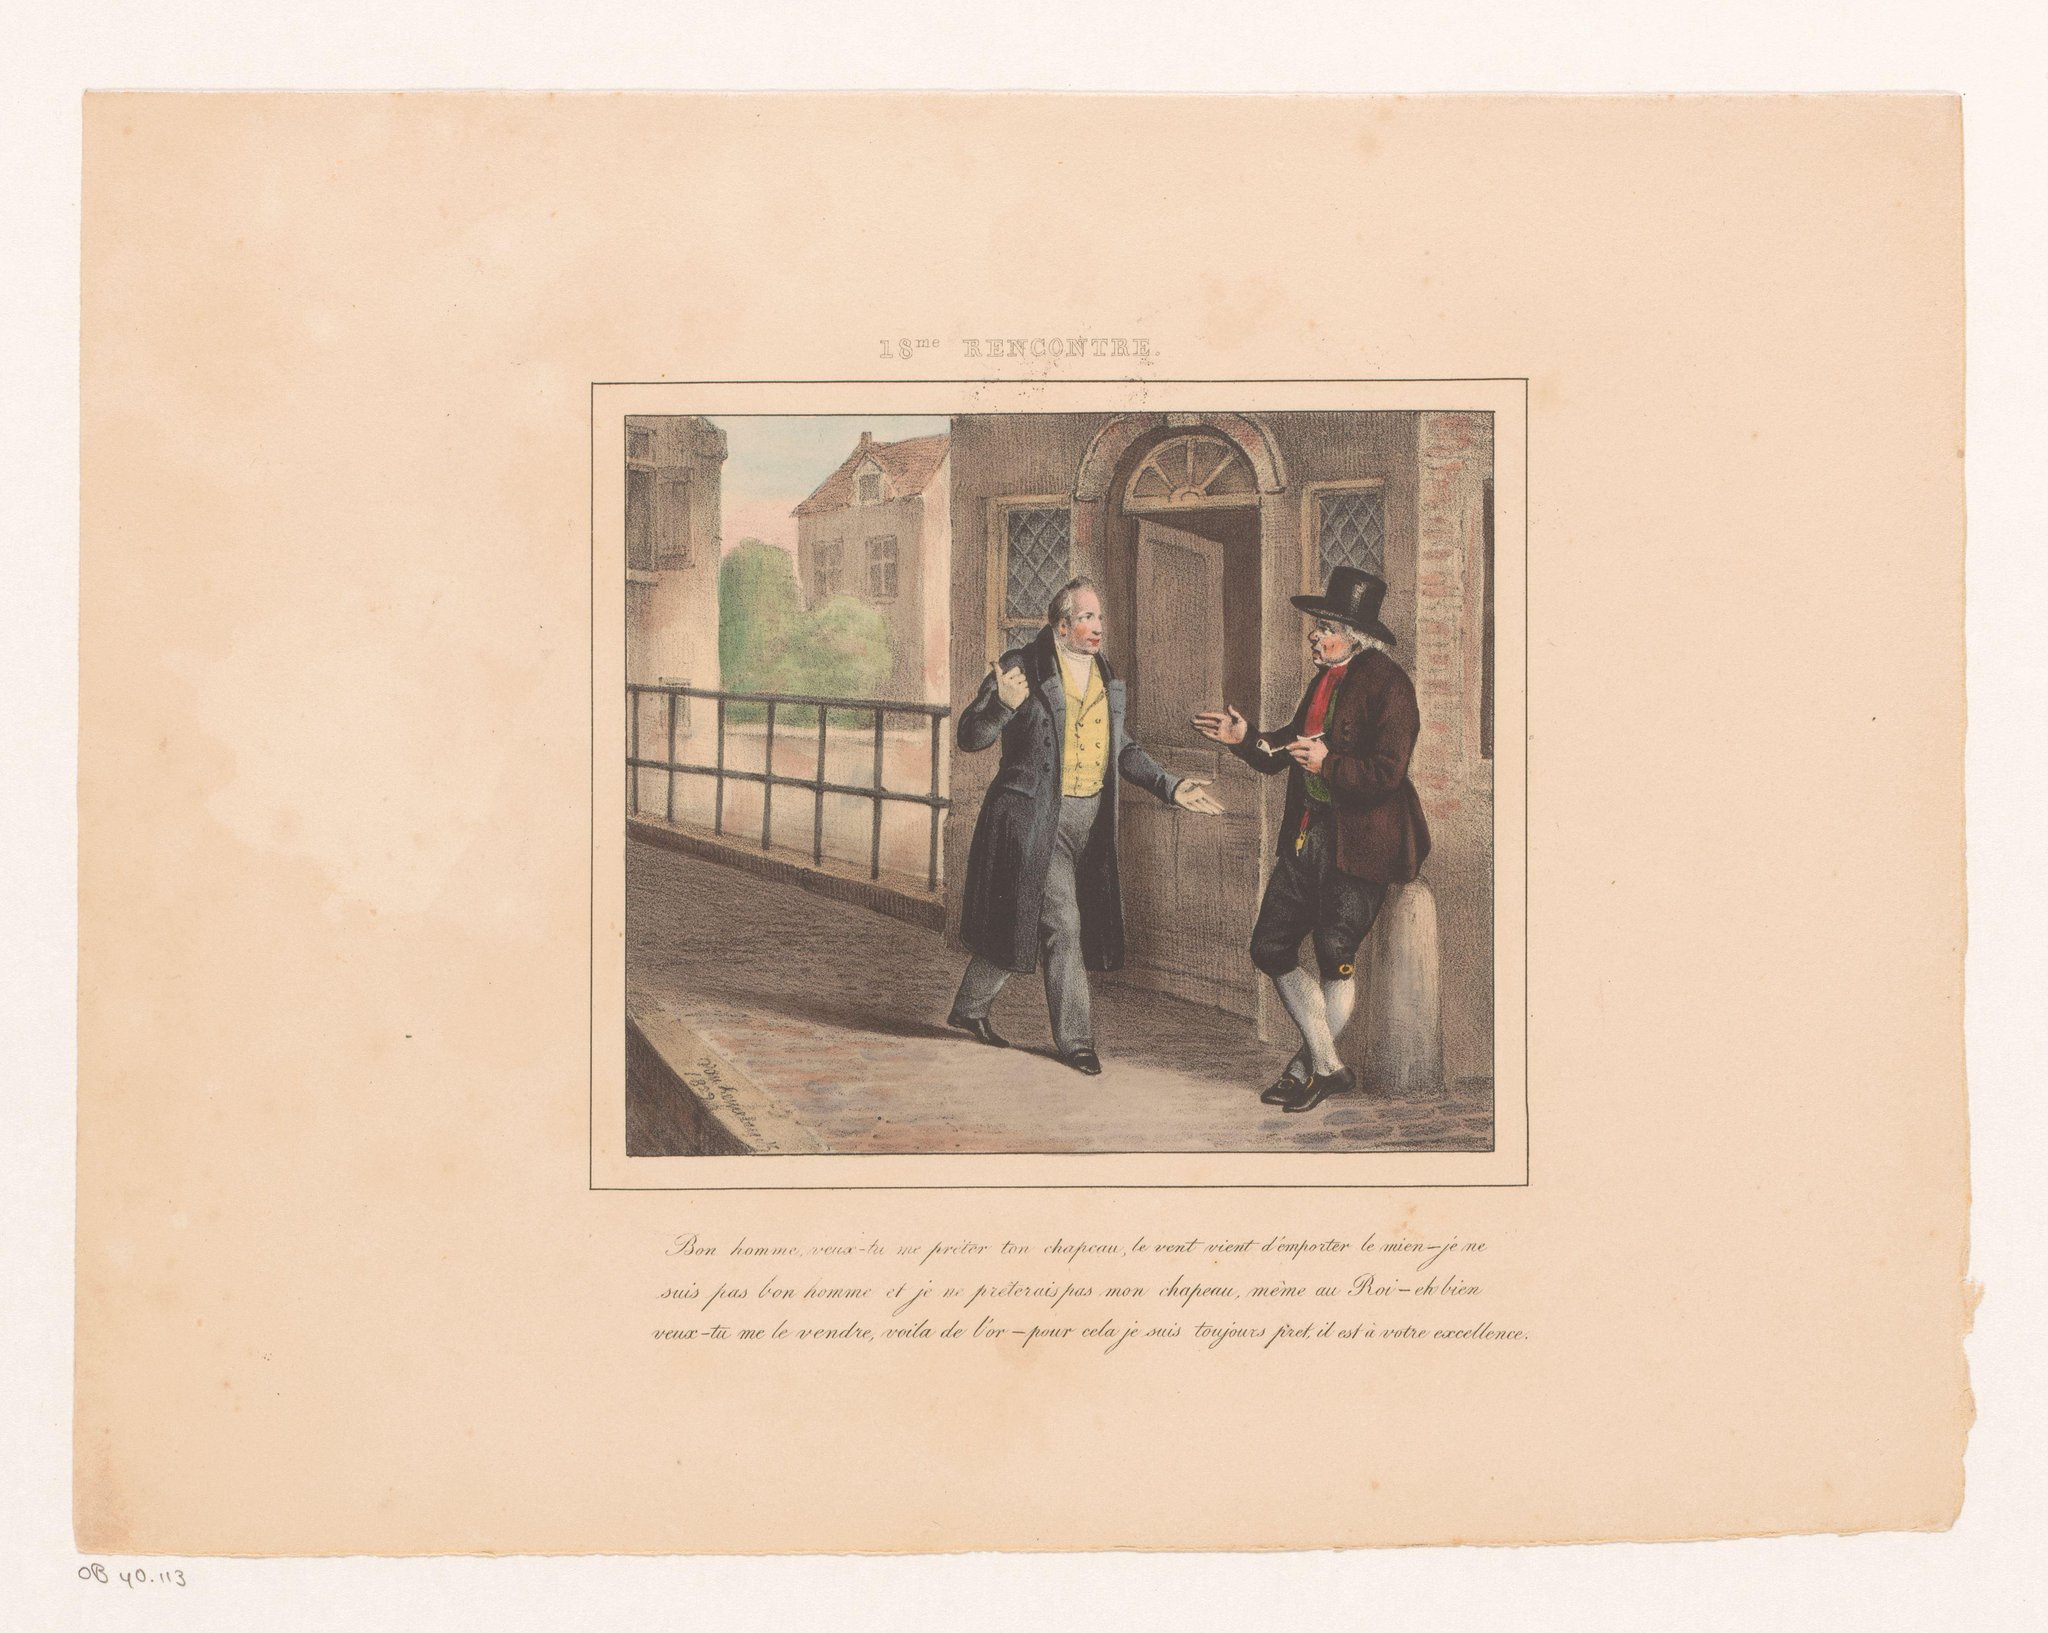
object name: print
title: Les rencontres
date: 1829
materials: paper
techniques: hand coloring, lithograph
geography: brussels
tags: the hague, berlin, william i of the netherlands, ruler in informal contact with his subjects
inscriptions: collector's mark: Lugt 2228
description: De koning, wiens hoed in het water was gewaaid, vraagt een in de nabijheid staande man zijn hoed te leen. Met drieregelig onderschrift. Onderdeel van de serie van 24 platen met ontmoetingen met koning Willem I, verschenen onder de titel 'Les rencontres' in 1829-1830.